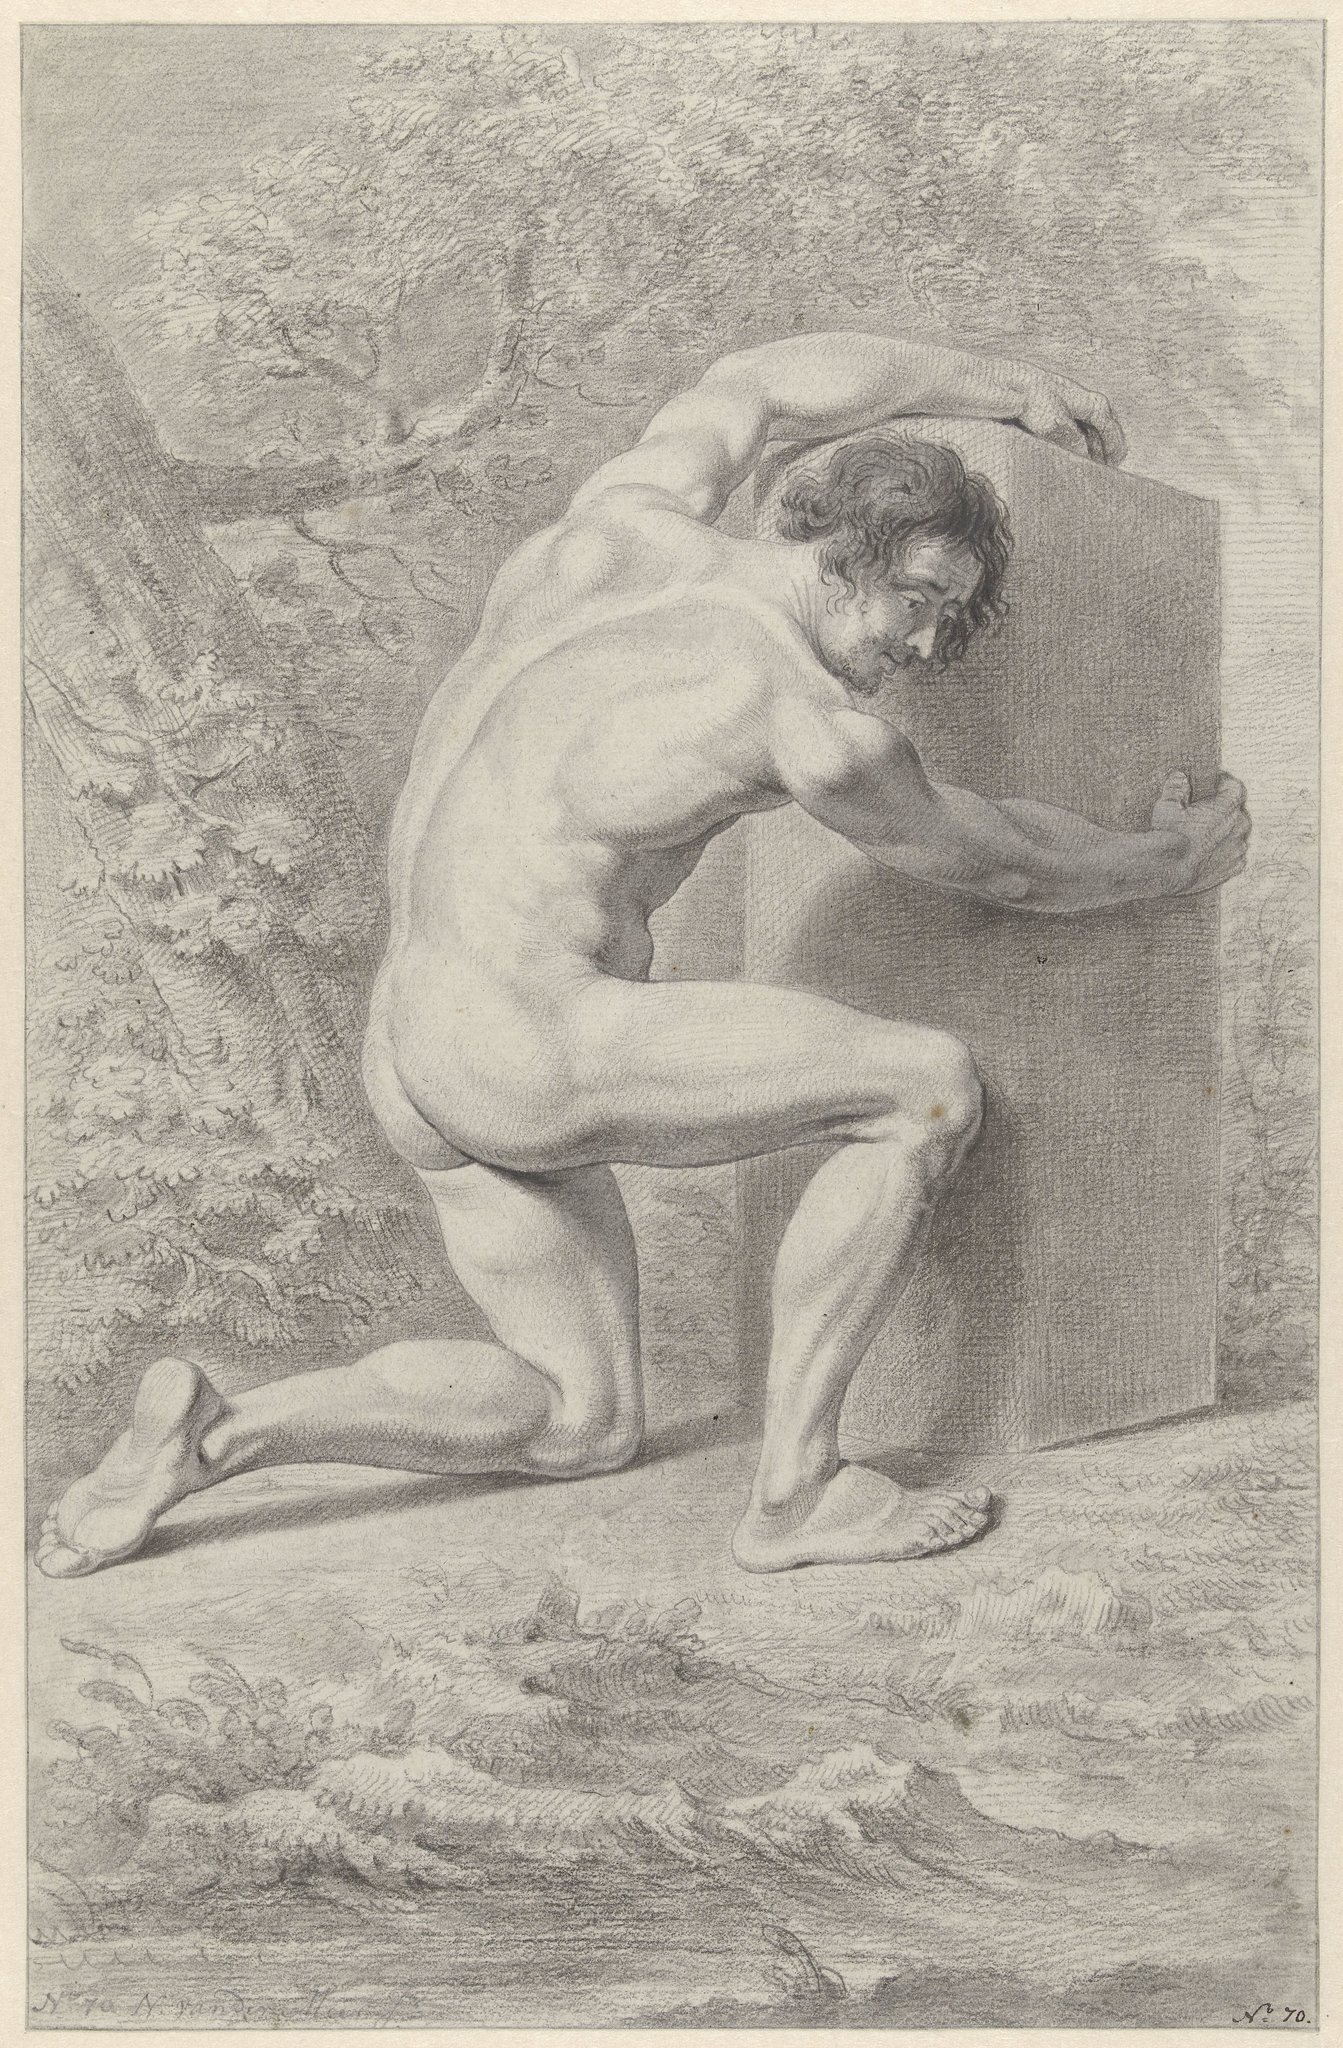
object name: drawing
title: Knielend mannelijk naakt, de armen om een blok geslagen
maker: noach van der meer (ii)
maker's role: draughtsman, print maker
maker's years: 1741-1822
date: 1751-1822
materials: chalk, paper